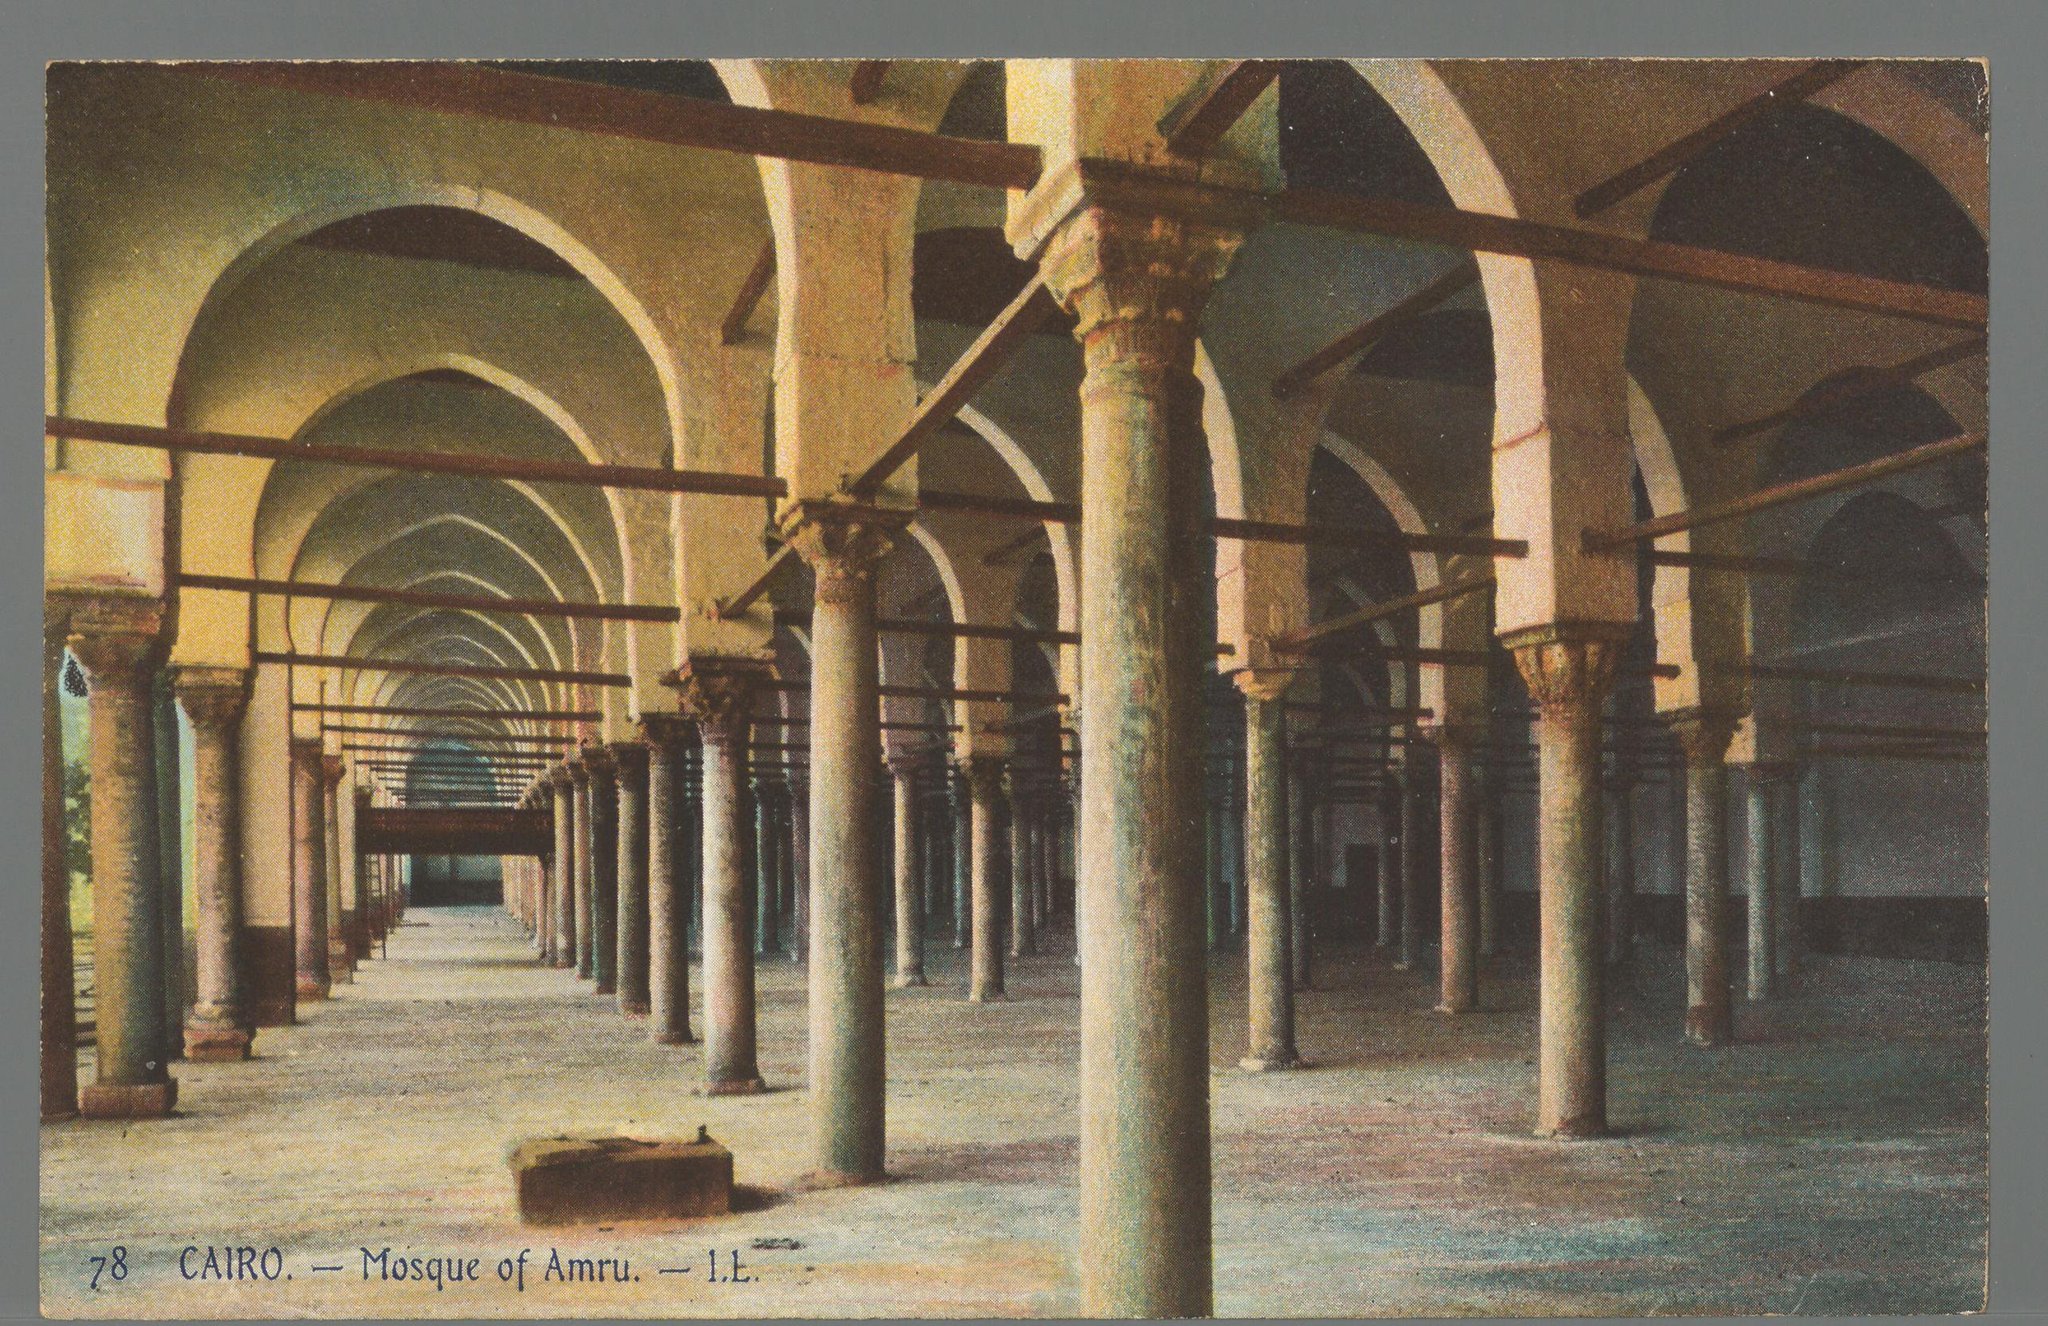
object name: photomechanical print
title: Cairo - Mosque of Amru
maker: Anonymous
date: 1907-1930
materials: cardboard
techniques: lithograph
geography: cairo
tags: garden, temple, shrine ~ islam, mohammedanism